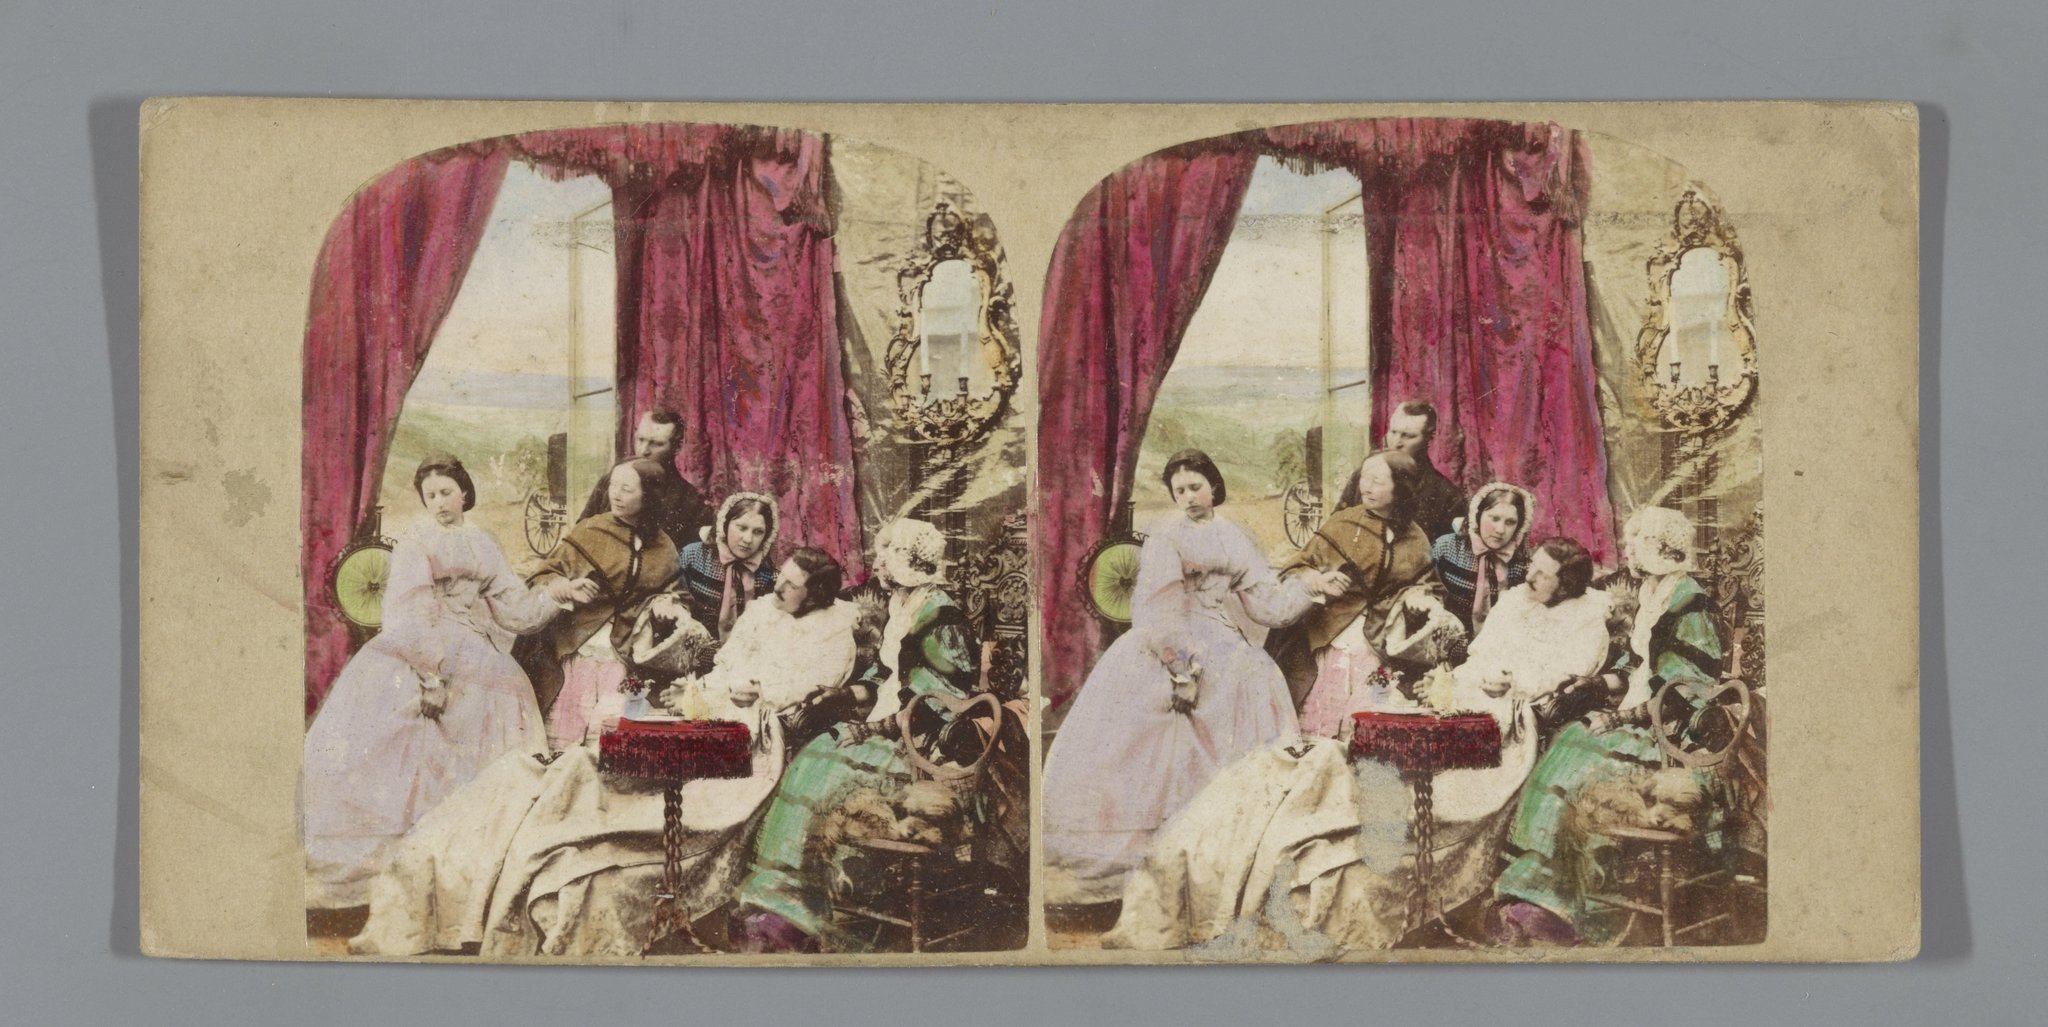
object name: stereograph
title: Love is the best Physician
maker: Anonymous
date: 1852-1863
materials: cardboard, paper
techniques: albumen print, hand coloring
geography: london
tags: visiting the sick; sick person together with others